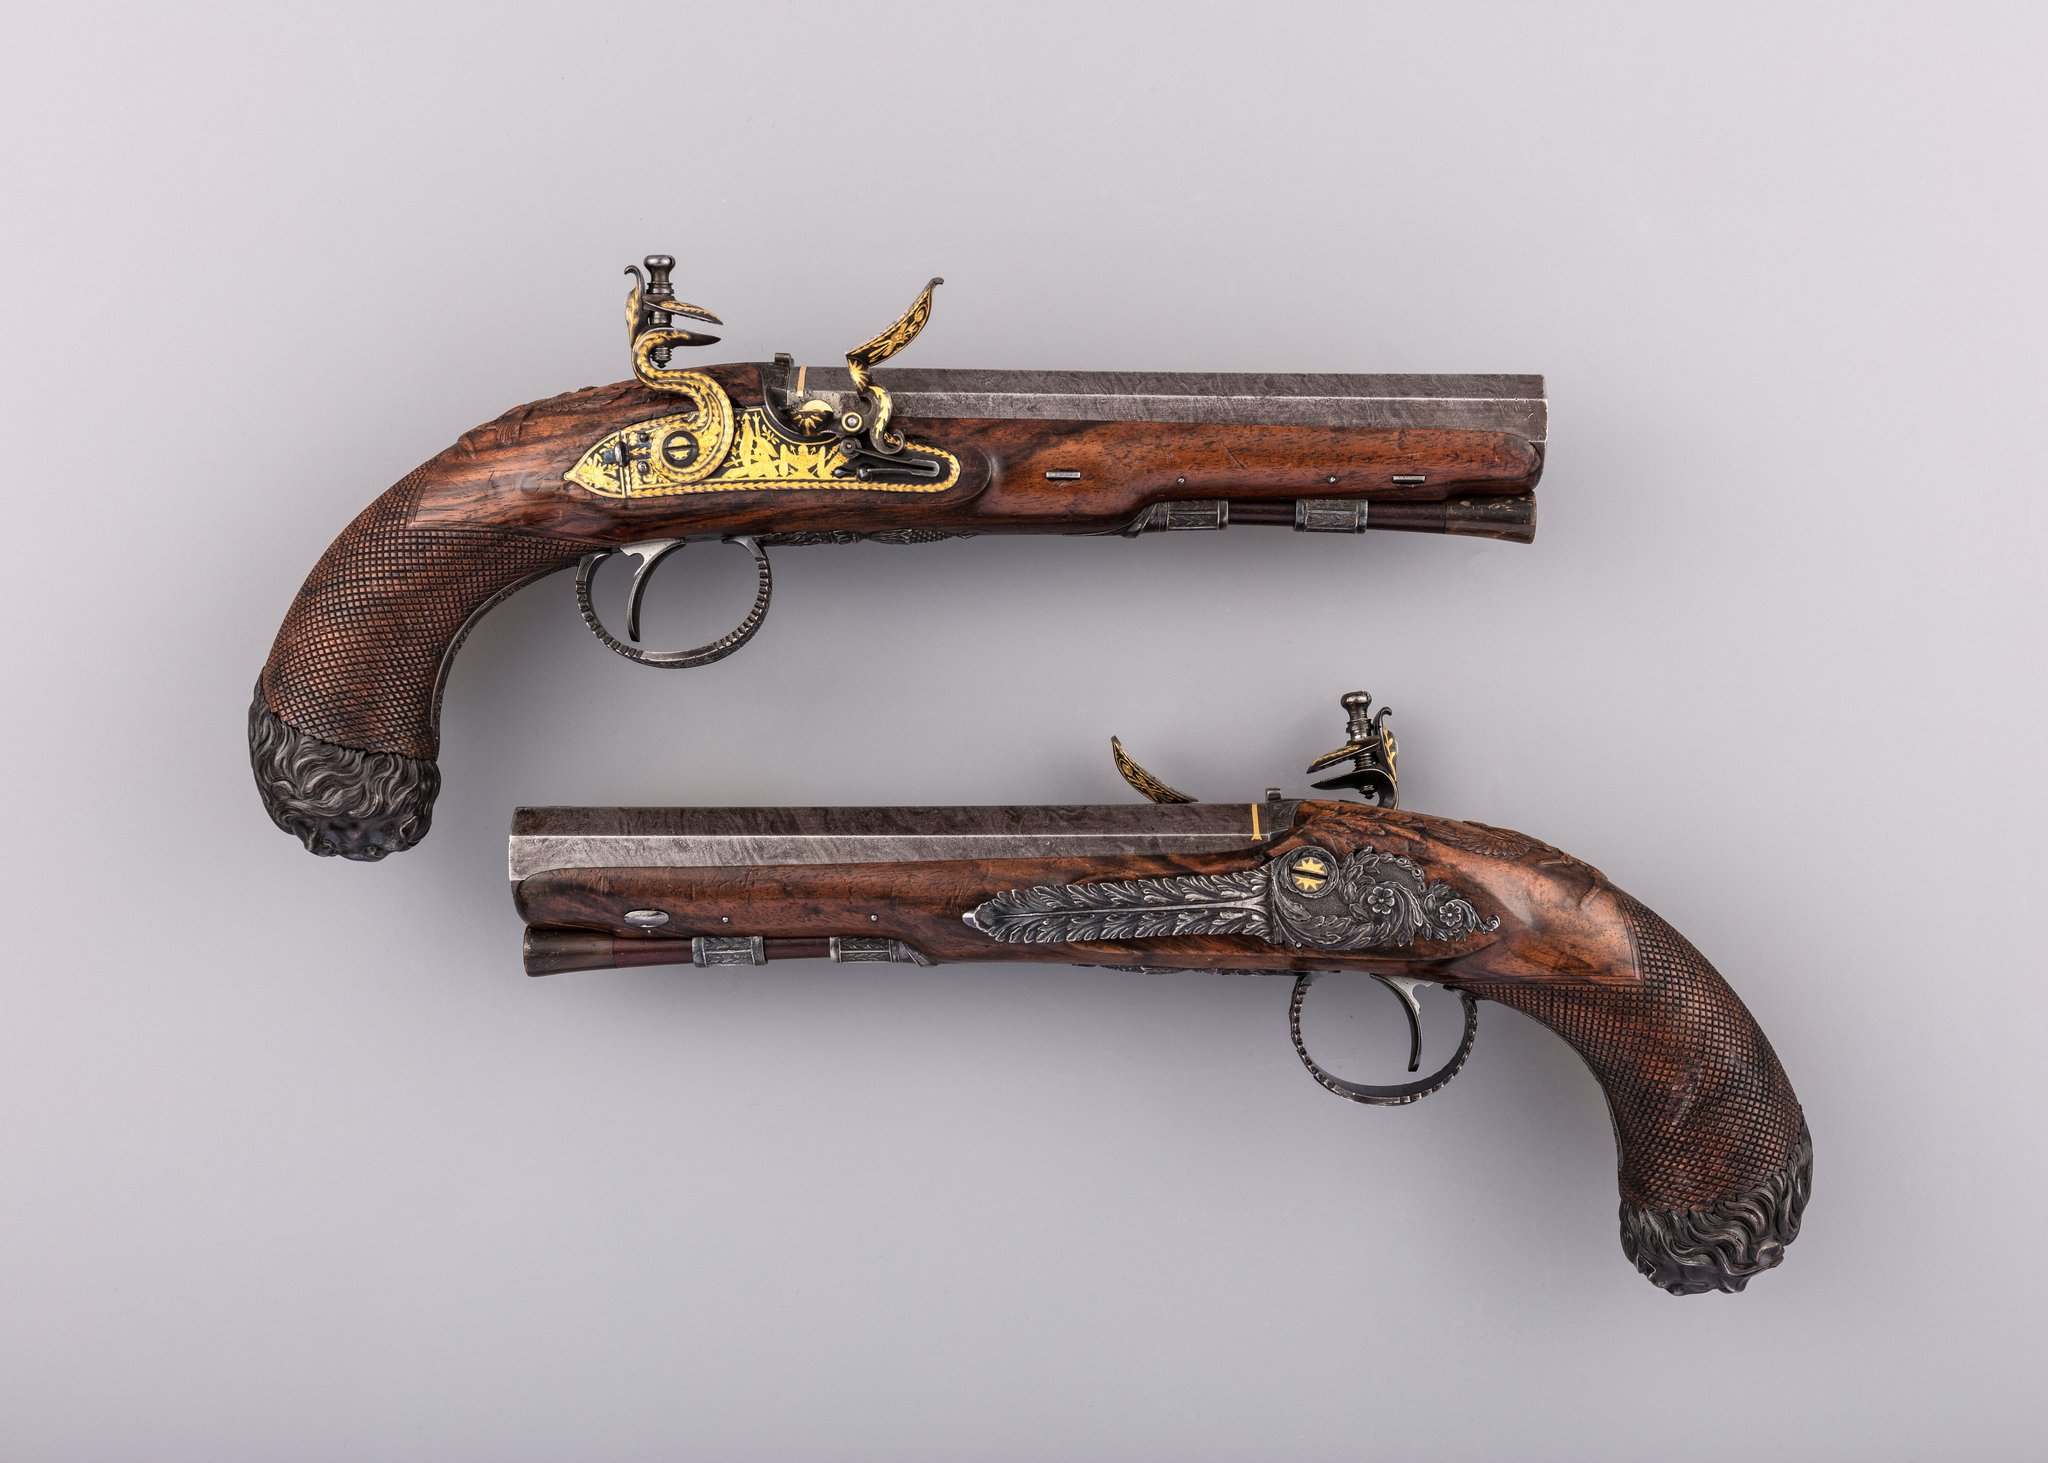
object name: pair of flintlock pistol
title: Pair of Flintlock Pistols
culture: british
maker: john manton & son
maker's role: gunsmith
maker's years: 1815-1878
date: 1815-1834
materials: gold, horn, steel, wood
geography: england